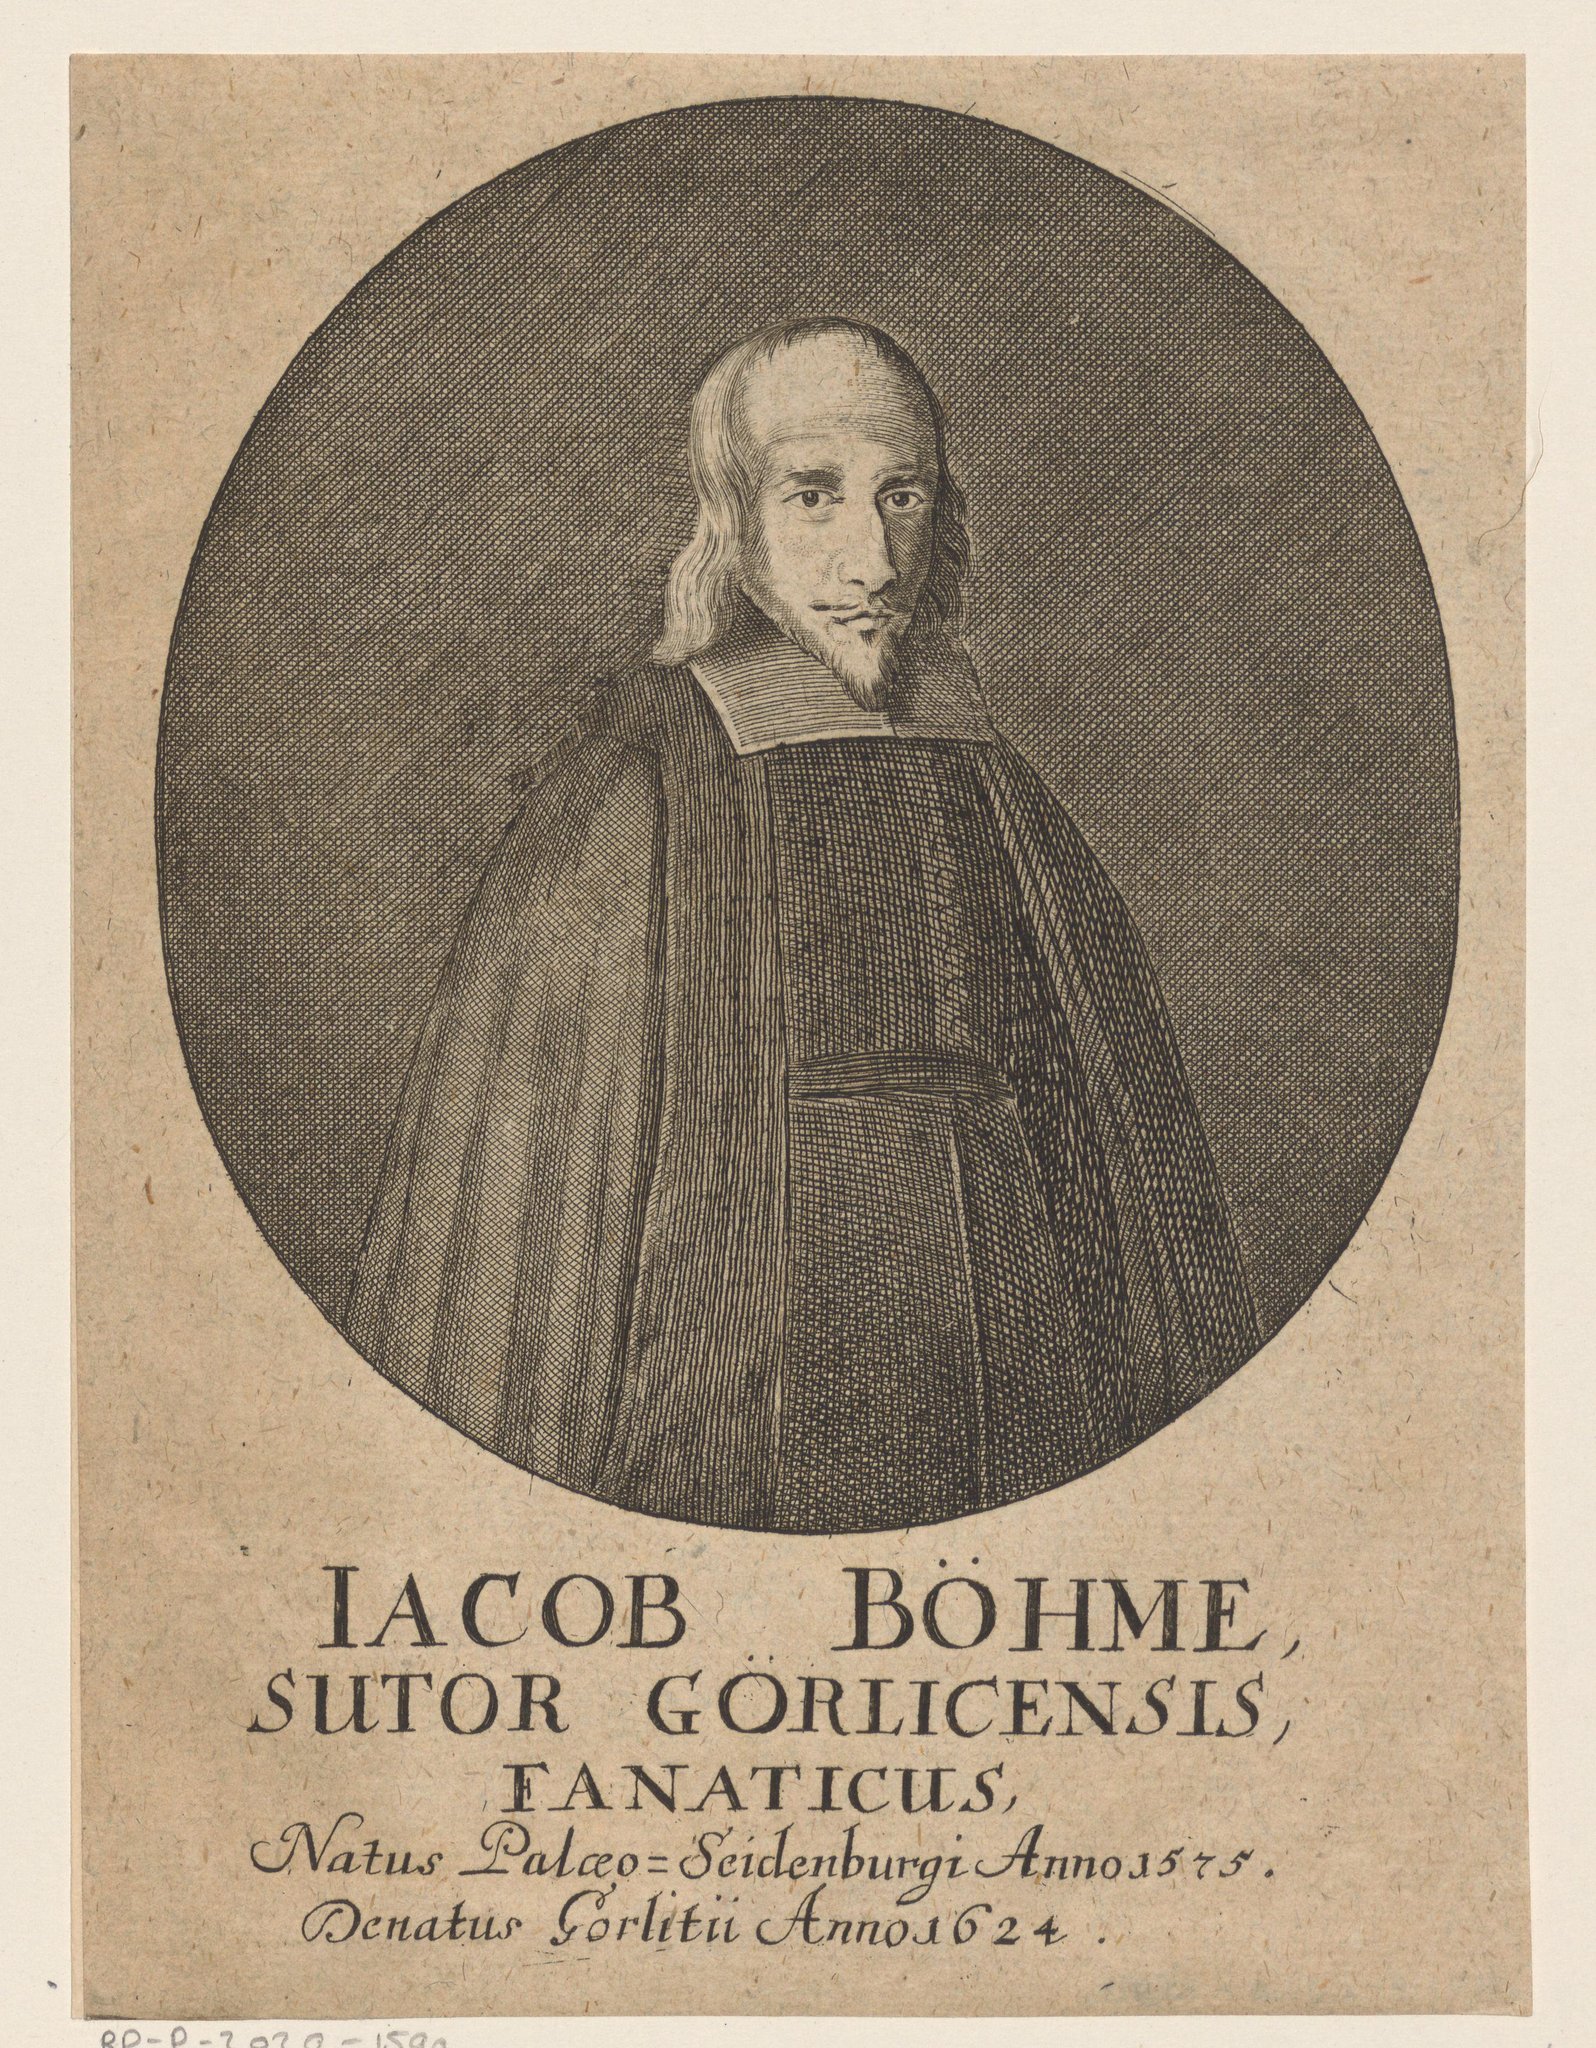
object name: print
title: Portret van Jakob Böhme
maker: Anonymous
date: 1700-1710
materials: paper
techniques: engraving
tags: theologian, historical persons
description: Prent mogelijk uit: Theobald, Zacharias. Der Alten und Neuen Schwärmer Widertäufferischer Geist (...). Köthen: Wilhelm Andreas, 1701.